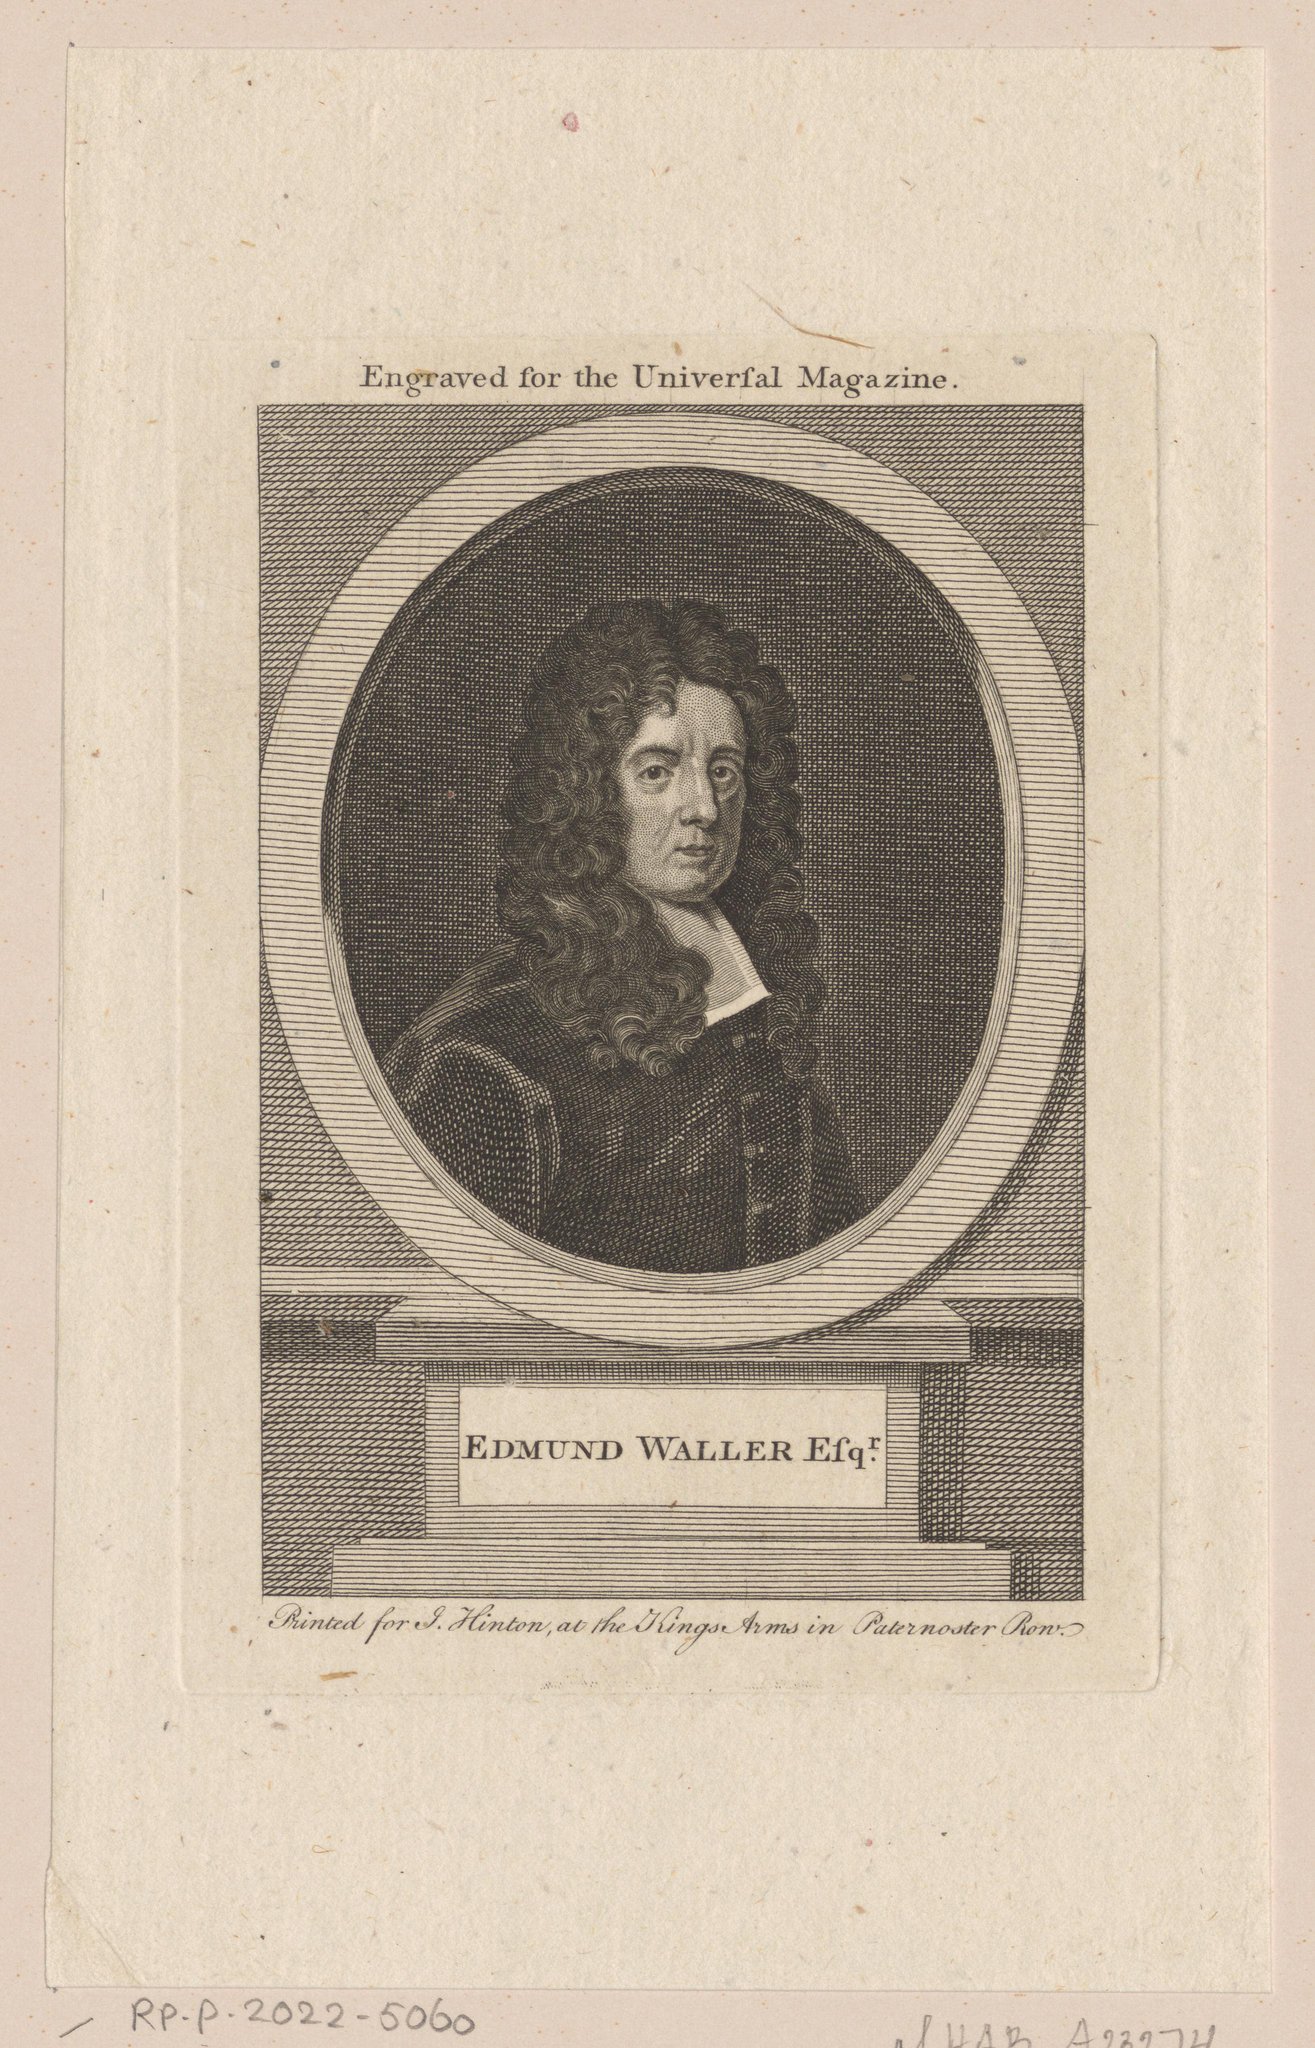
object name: print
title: Portret van Edmund Waller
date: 1774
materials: paper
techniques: engraving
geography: england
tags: politician, historical persons, politician, e.g. party leader, writer, poet, author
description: Prent uit: The Universal Magazine, 1774, dl. 54.